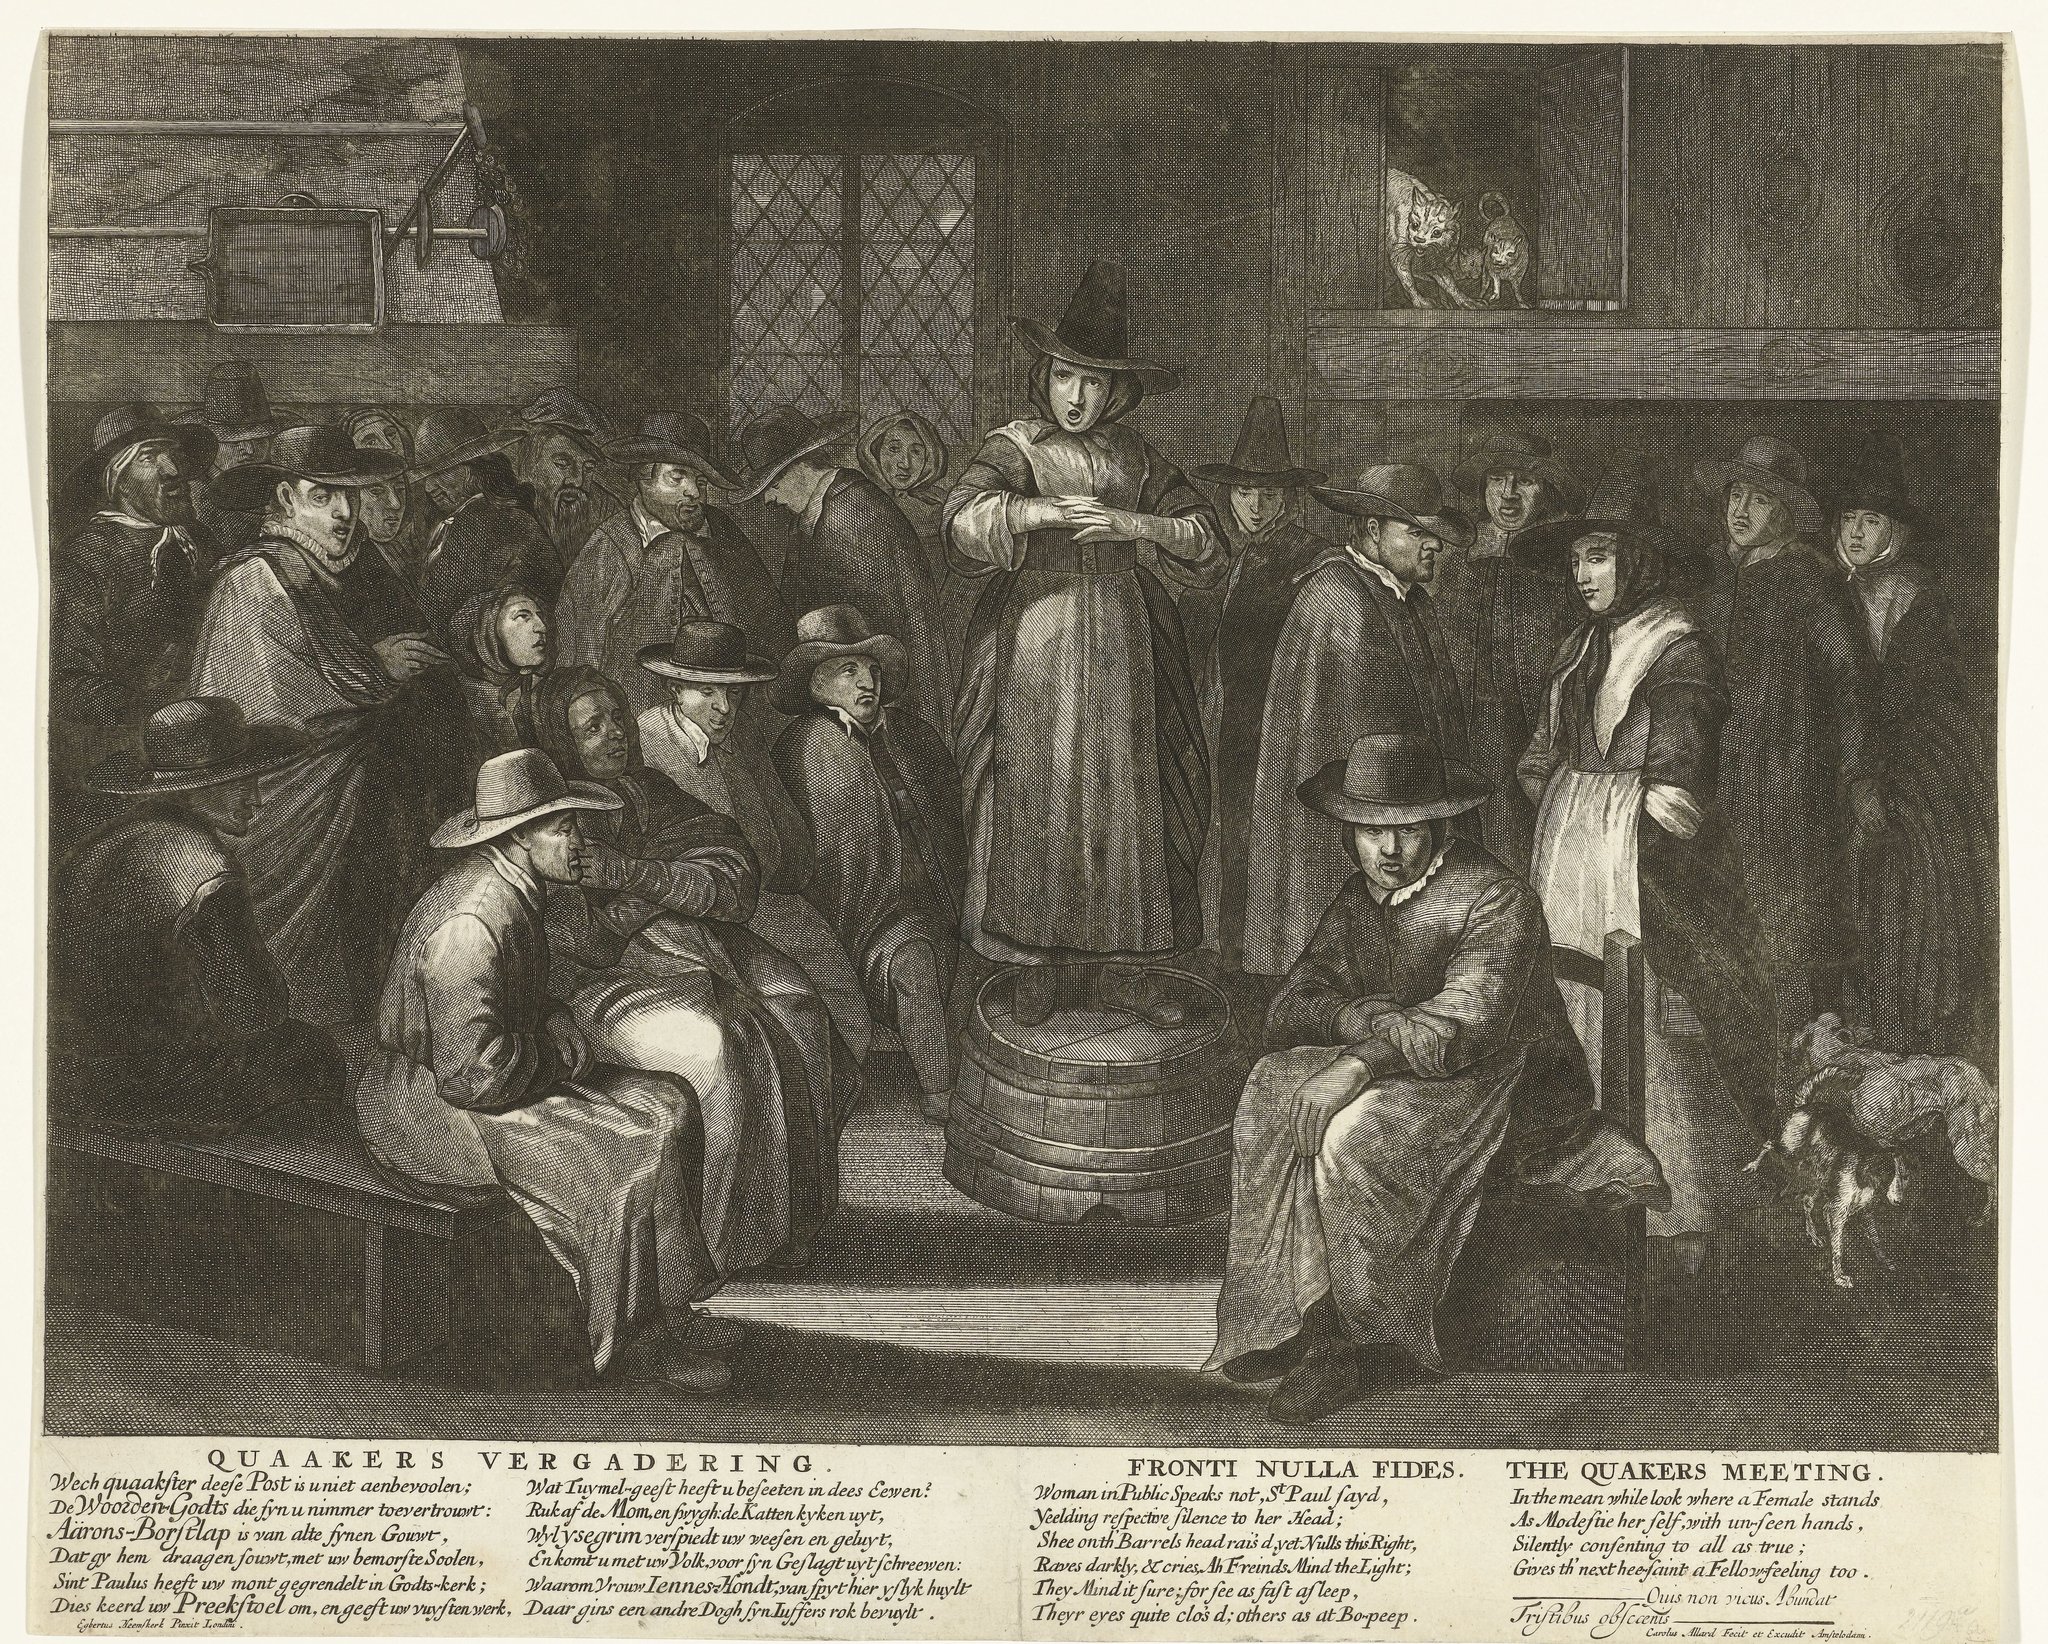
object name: print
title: Spotprent op de Engelse Quakers, ca. 1656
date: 1675-1699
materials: paper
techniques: engraving, etching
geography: amsterdam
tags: protestant churches and denominations (with name), england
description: Spotprent op Engelse Quakers, ca. 1656. Bijeenkomst van Engelse mannen en vrouwen in het kostuum van de Quakers in een schuur, zij luisteren naar de preek van een vrouw die op een omgekeerde ton staat. Boven in een kastje miauwen katten, rechts plast een hond tegen de rok van een vrouw. In het onderschrift twee verzen in het Nederlands en Engels waarin de Quakers belachelijk worden gemaakt.